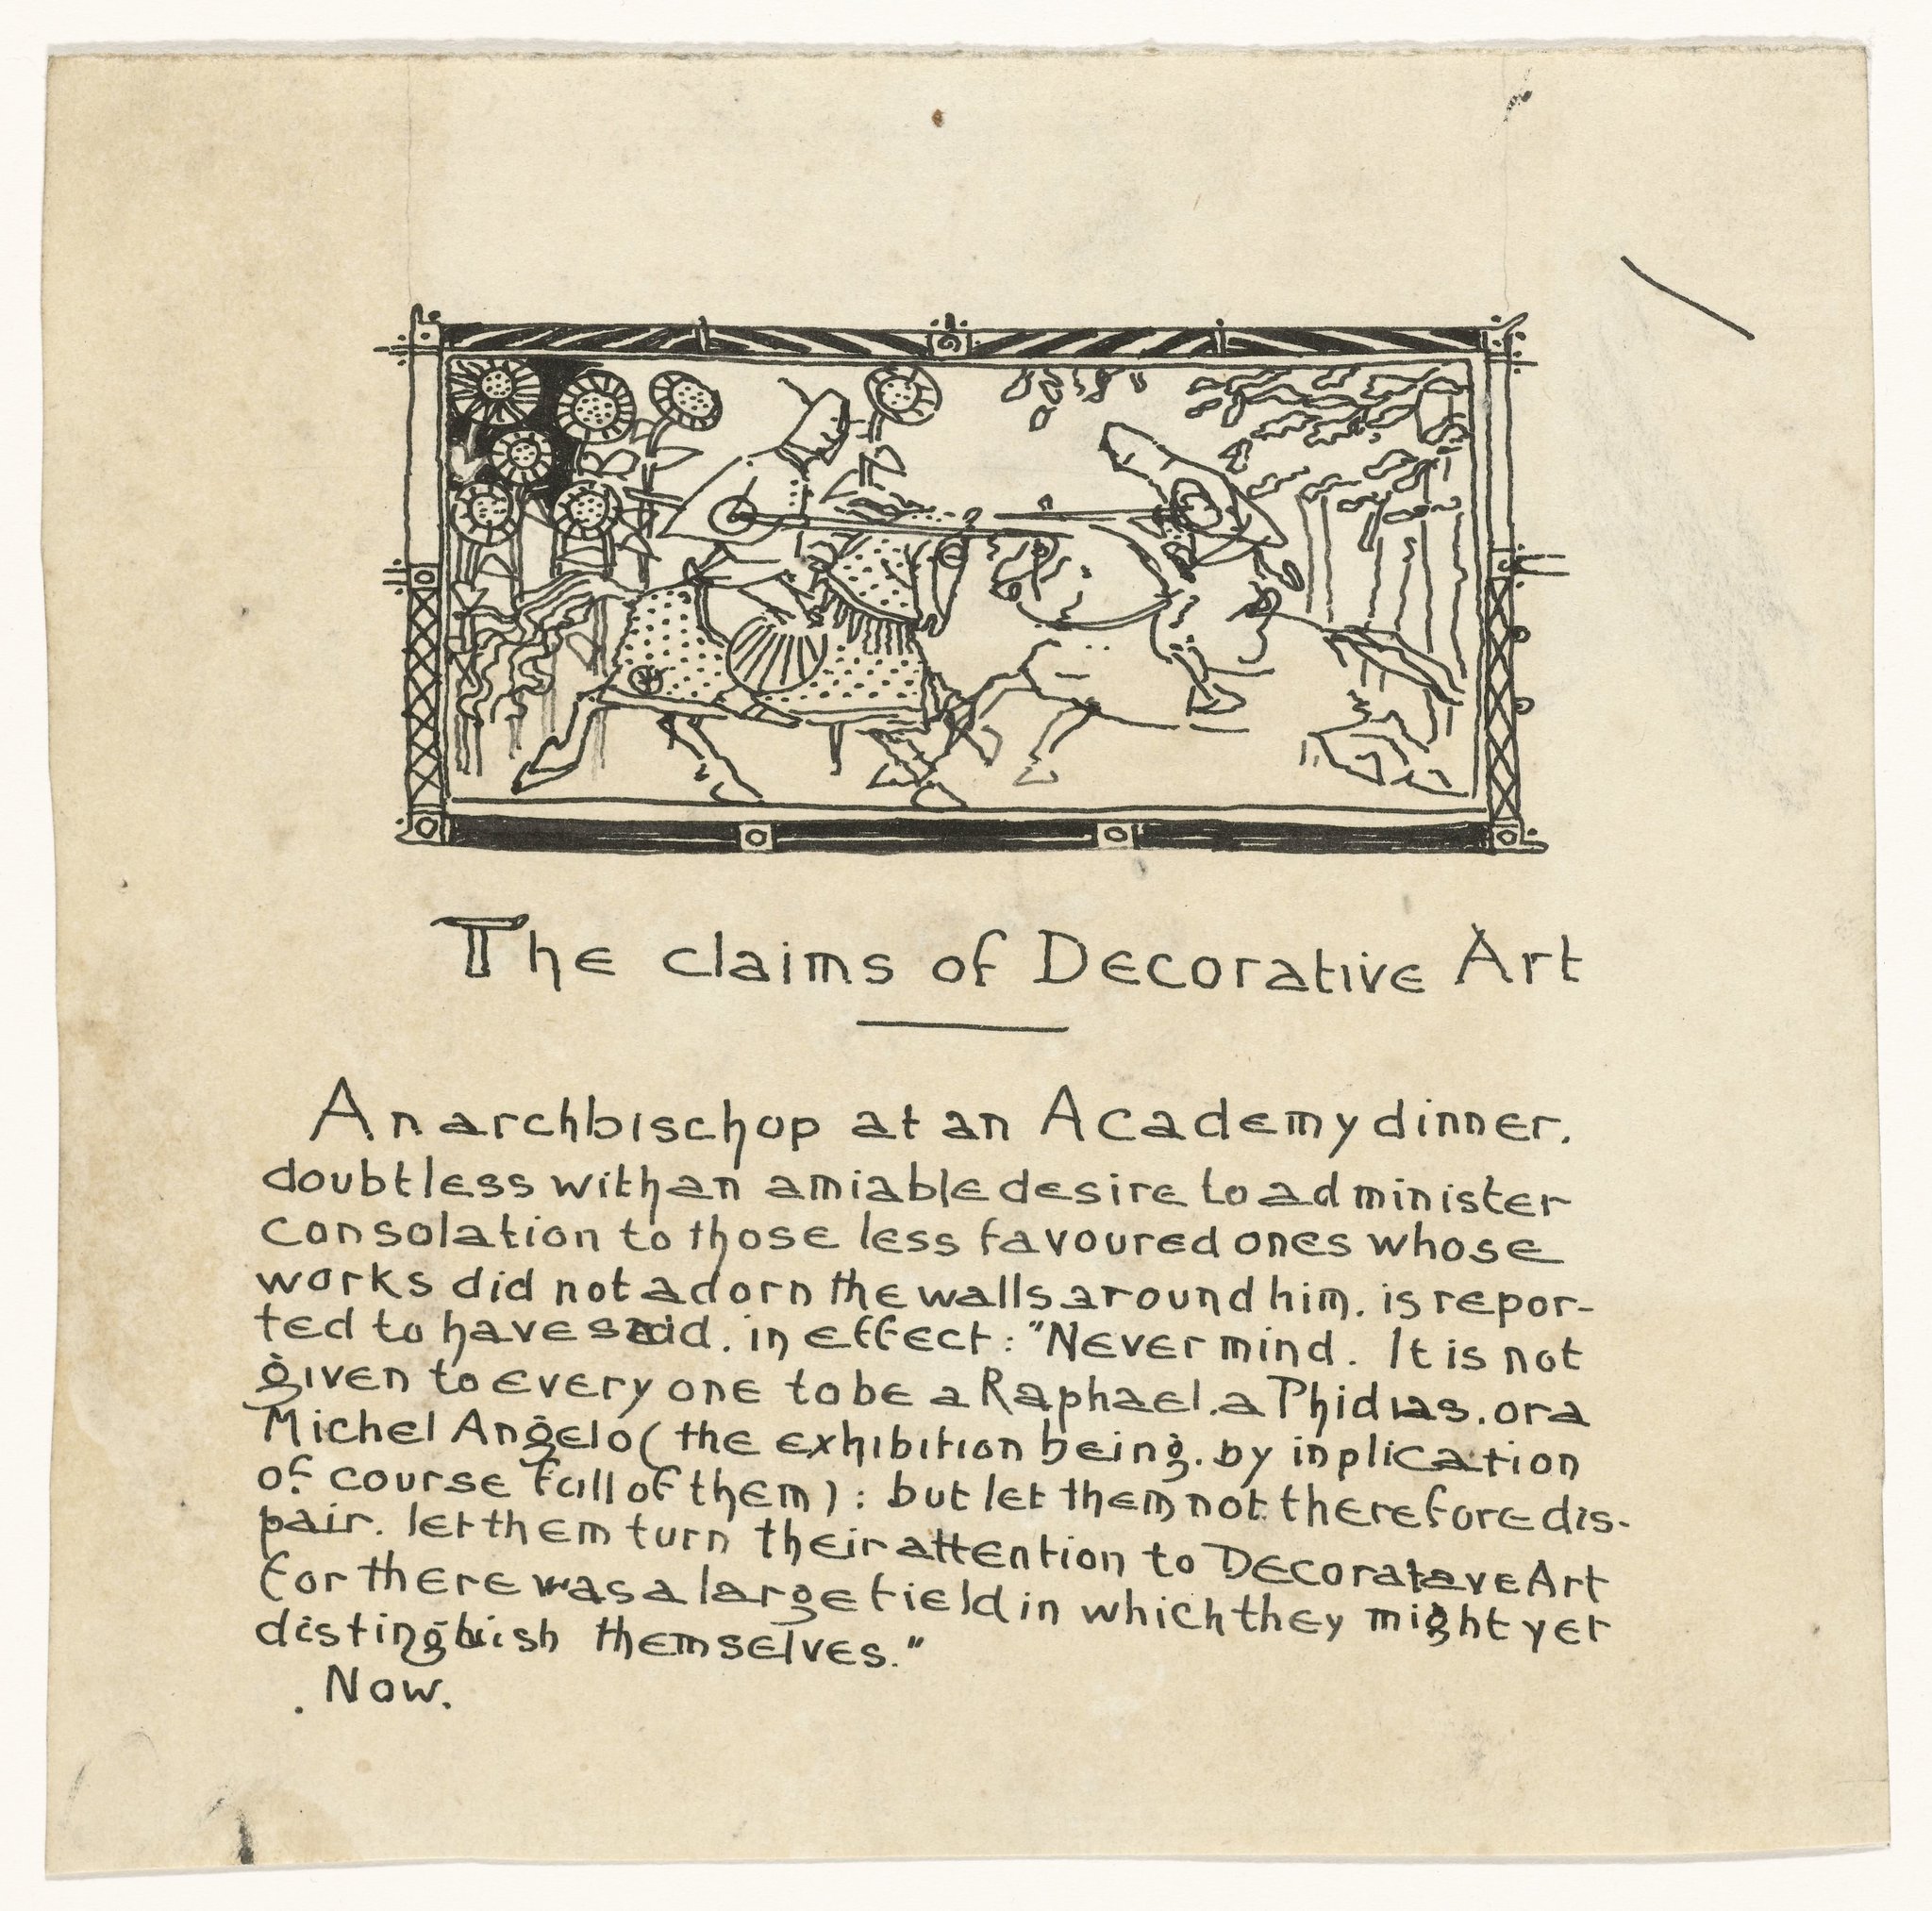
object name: drawing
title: Ontwerp voor voorwoord (?) van The claims of Decorative Art met illustratie van steekspel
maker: gerrit willem dijsselhof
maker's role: designer, draughtsman, print maker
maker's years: 1866-1924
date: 1876-1924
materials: ink, paper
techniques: pen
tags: (the claims of decorative art) specific works of literature (with author, title), title-page, joust, tilt